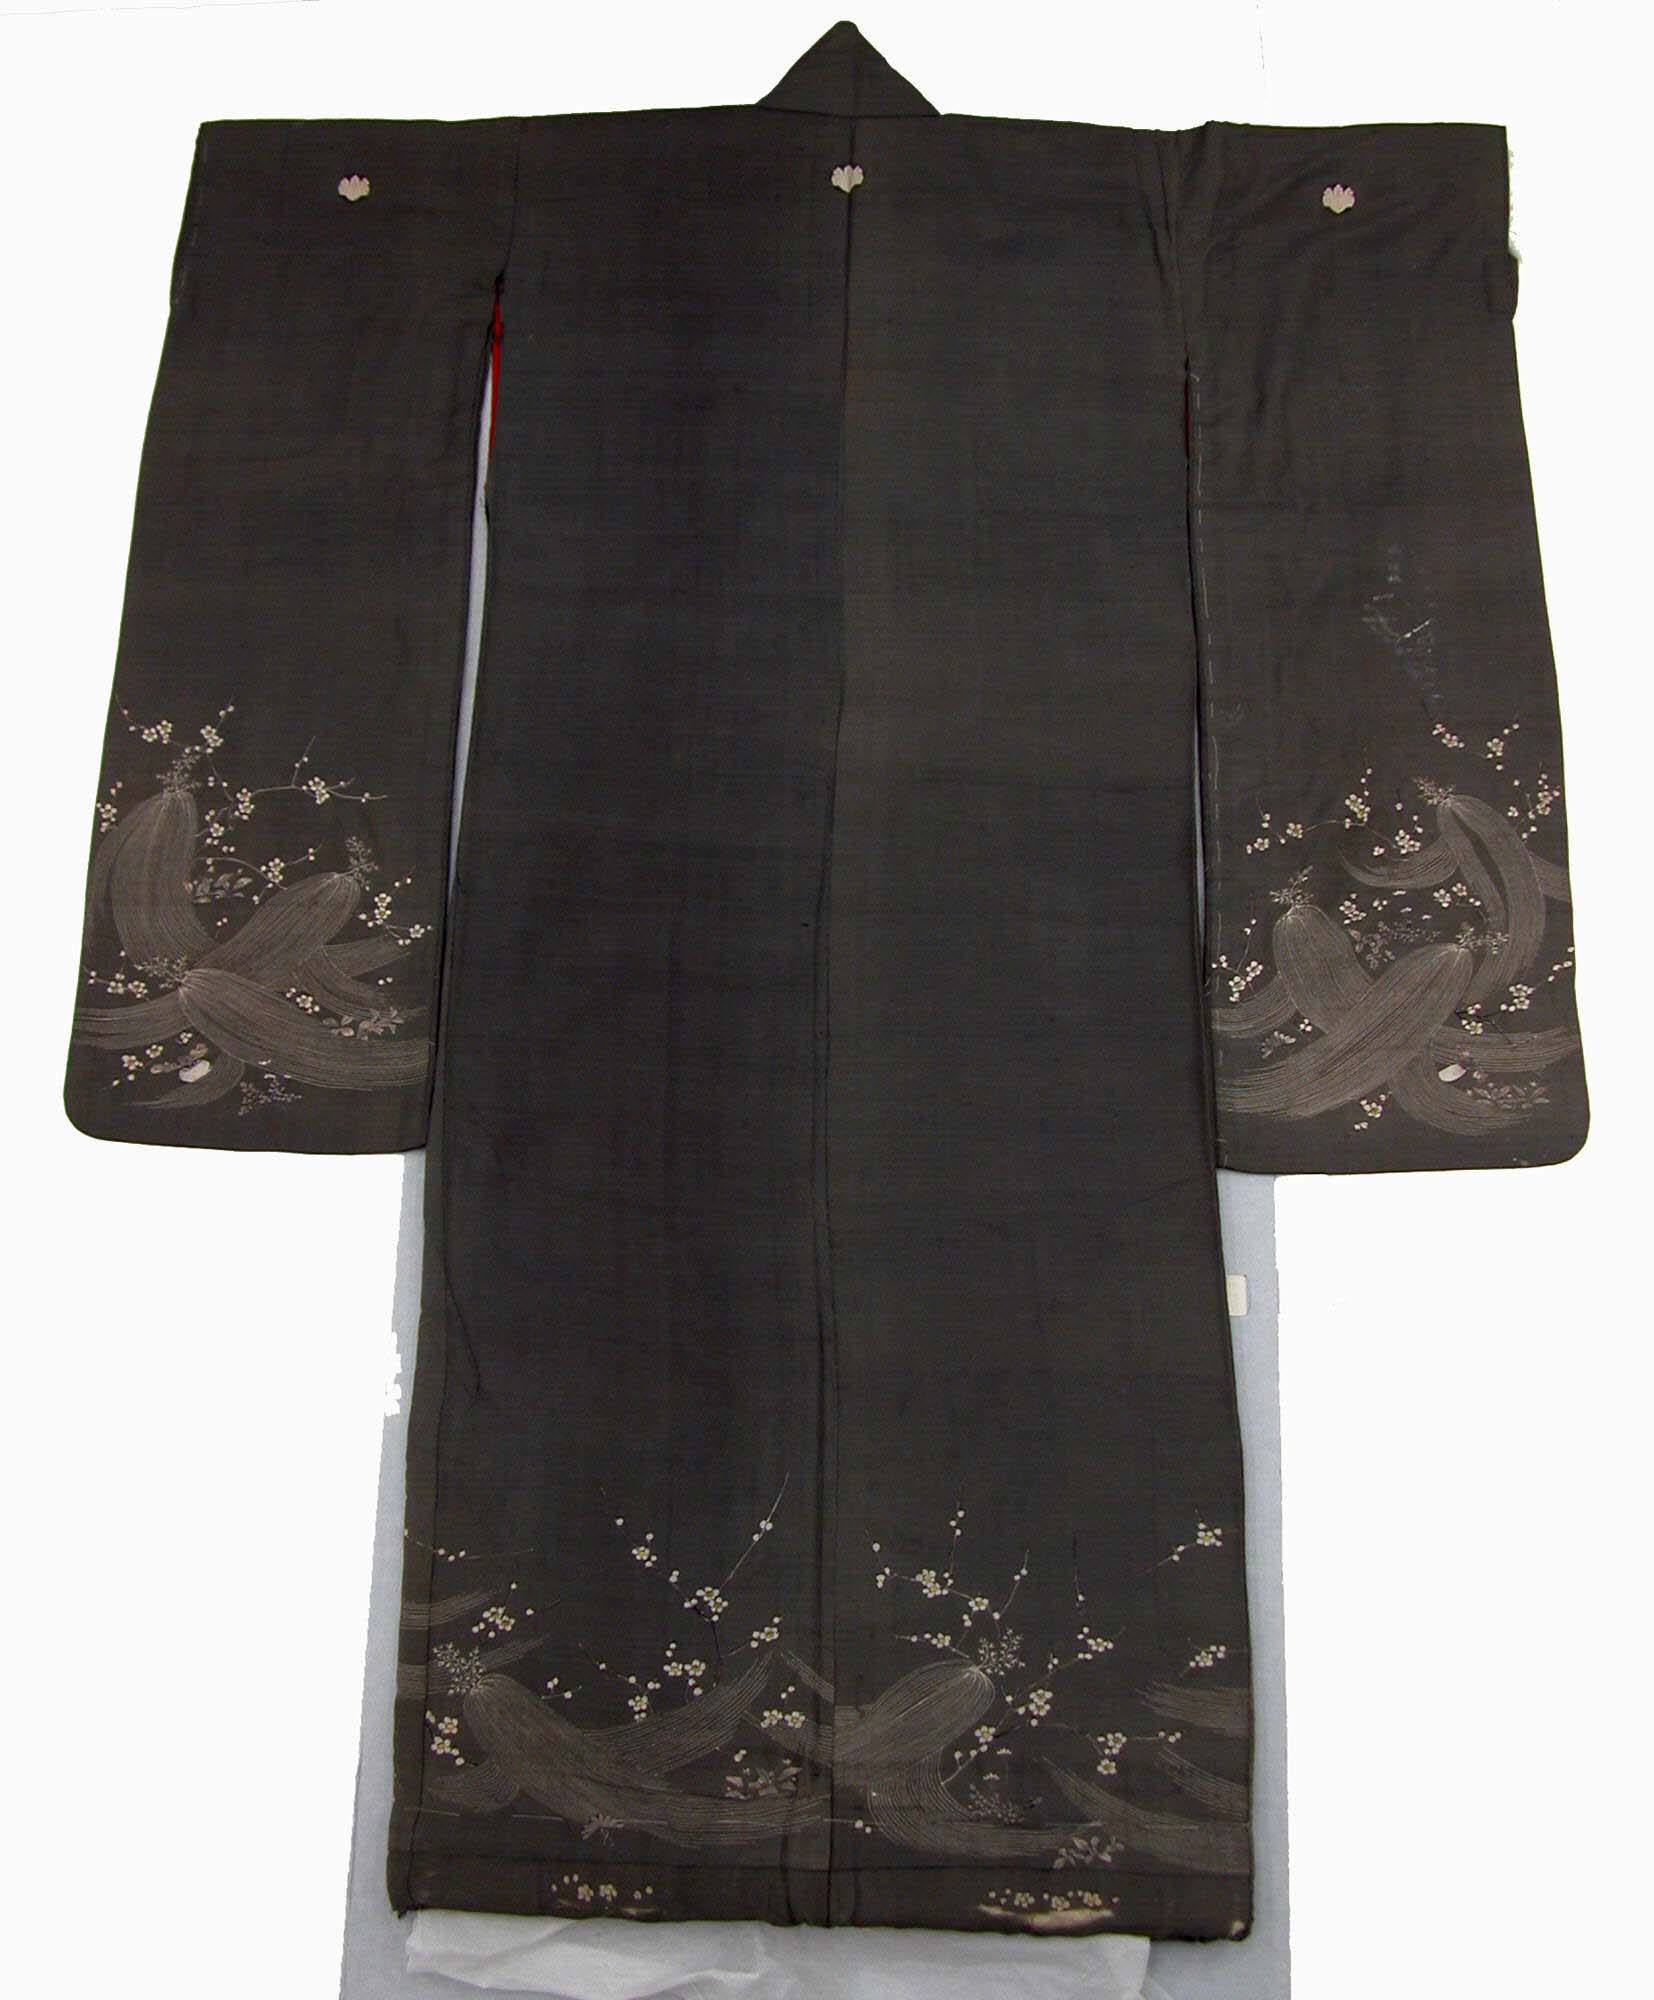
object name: woman's robe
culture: japanese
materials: silk